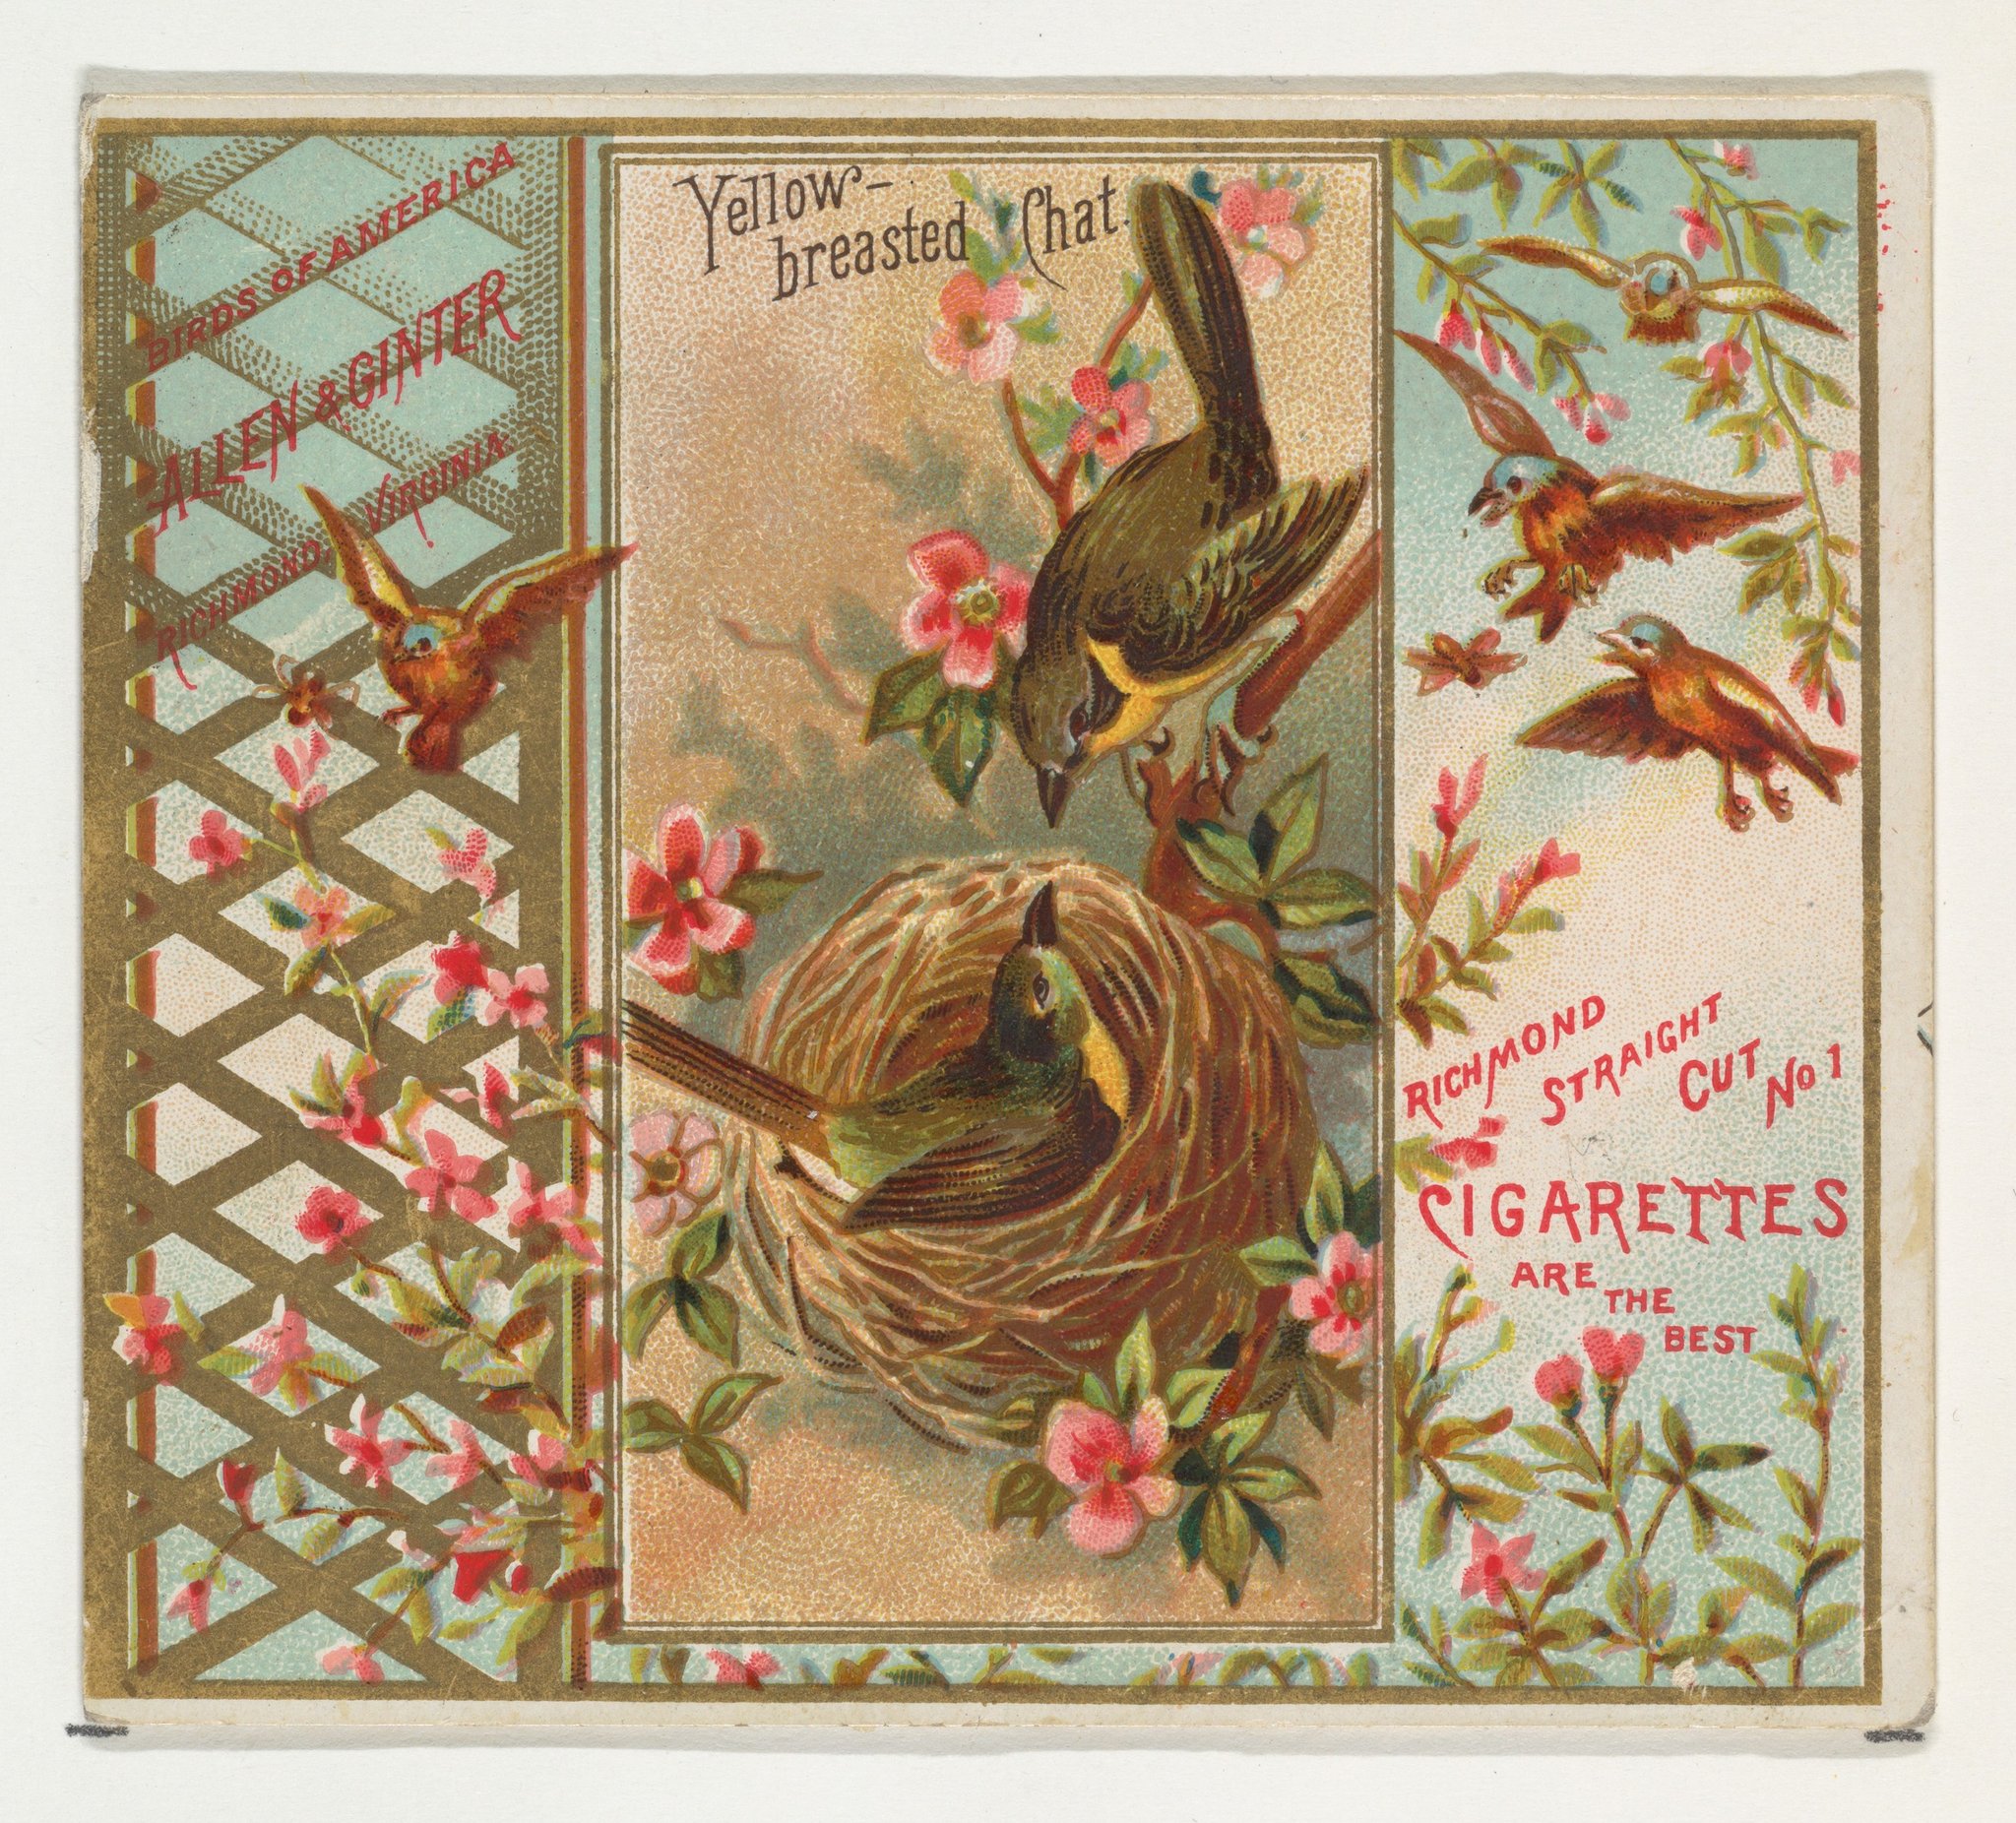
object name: print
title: Yellow-breasted Chat, from the Birds of America series (N37) for Allen & Ginter Cigarettes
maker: allen & ginter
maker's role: publisher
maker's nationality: american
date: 1888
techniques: color lithograph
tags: birds